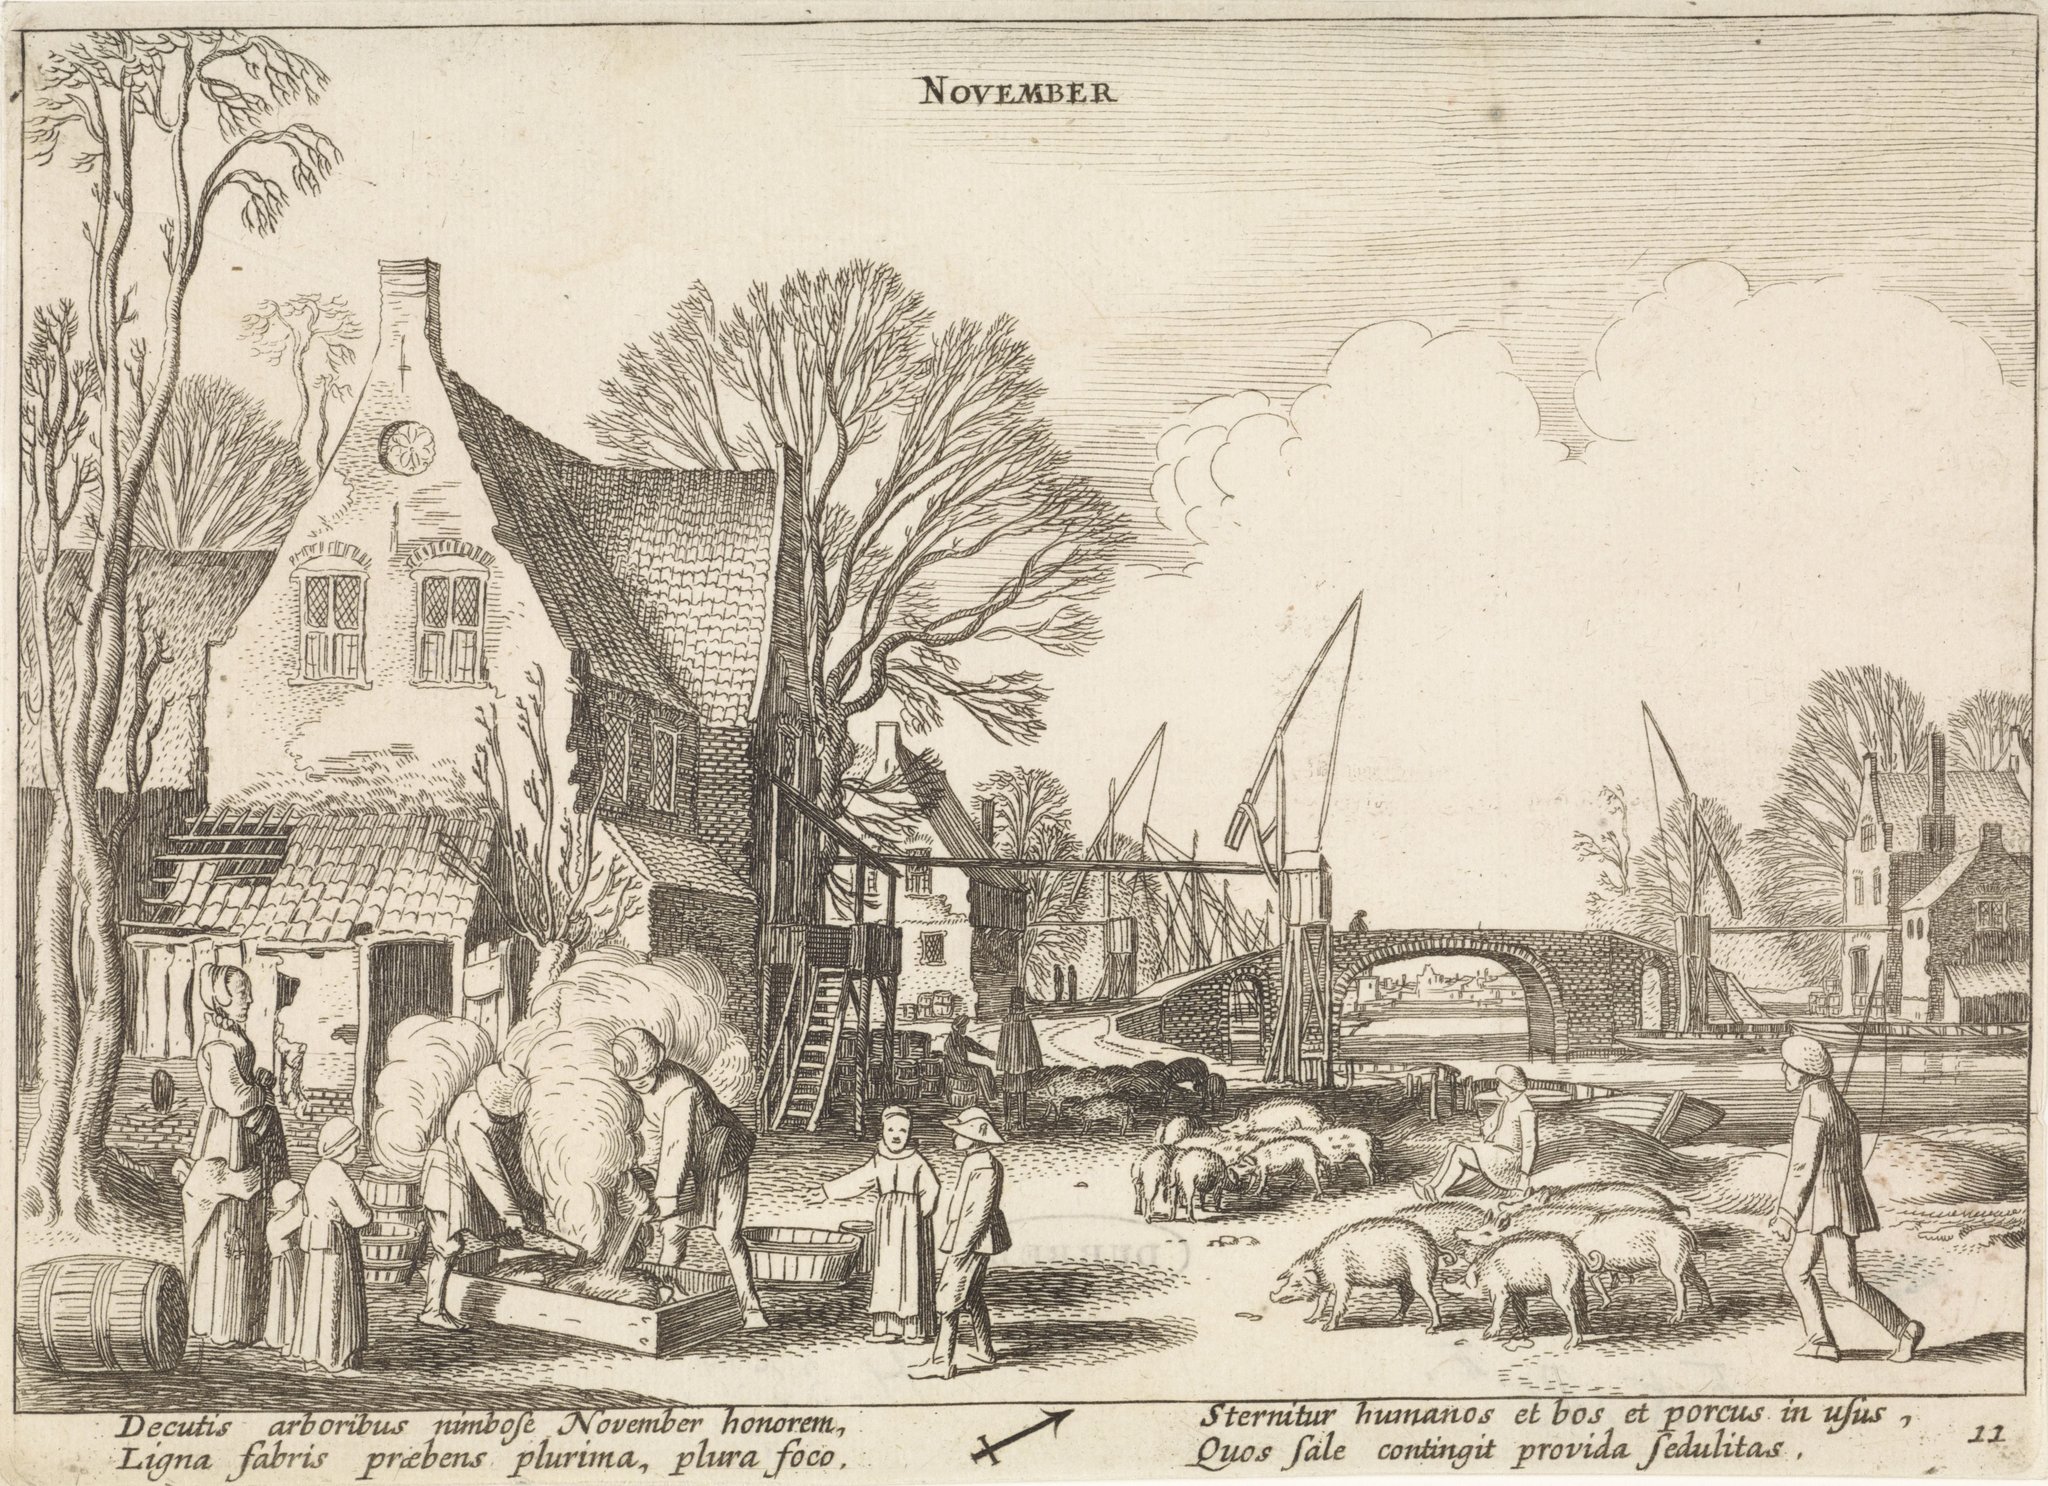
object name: print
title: Duodecim anni mensium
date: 1608-1618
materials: paper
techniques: etching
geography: northern netherlands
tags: landscape symbolizing november, pig, landscape with bridge, viaduct or aqueduct, sagittarius (zodiacal sign of november), village, slaughtered ox or pig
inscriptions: collector's mark: Lugt 698, collector's mark: Lugt 240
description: Een dorpsgezicht met varkenshoeders en links twee figuren die een dood varken wassen, voorstellende de maand november. In het midden een stenen brug. Onderaan het astrologische symbool van het sterrenbeeld boogschutter. Prent uit een serie van twaalf.